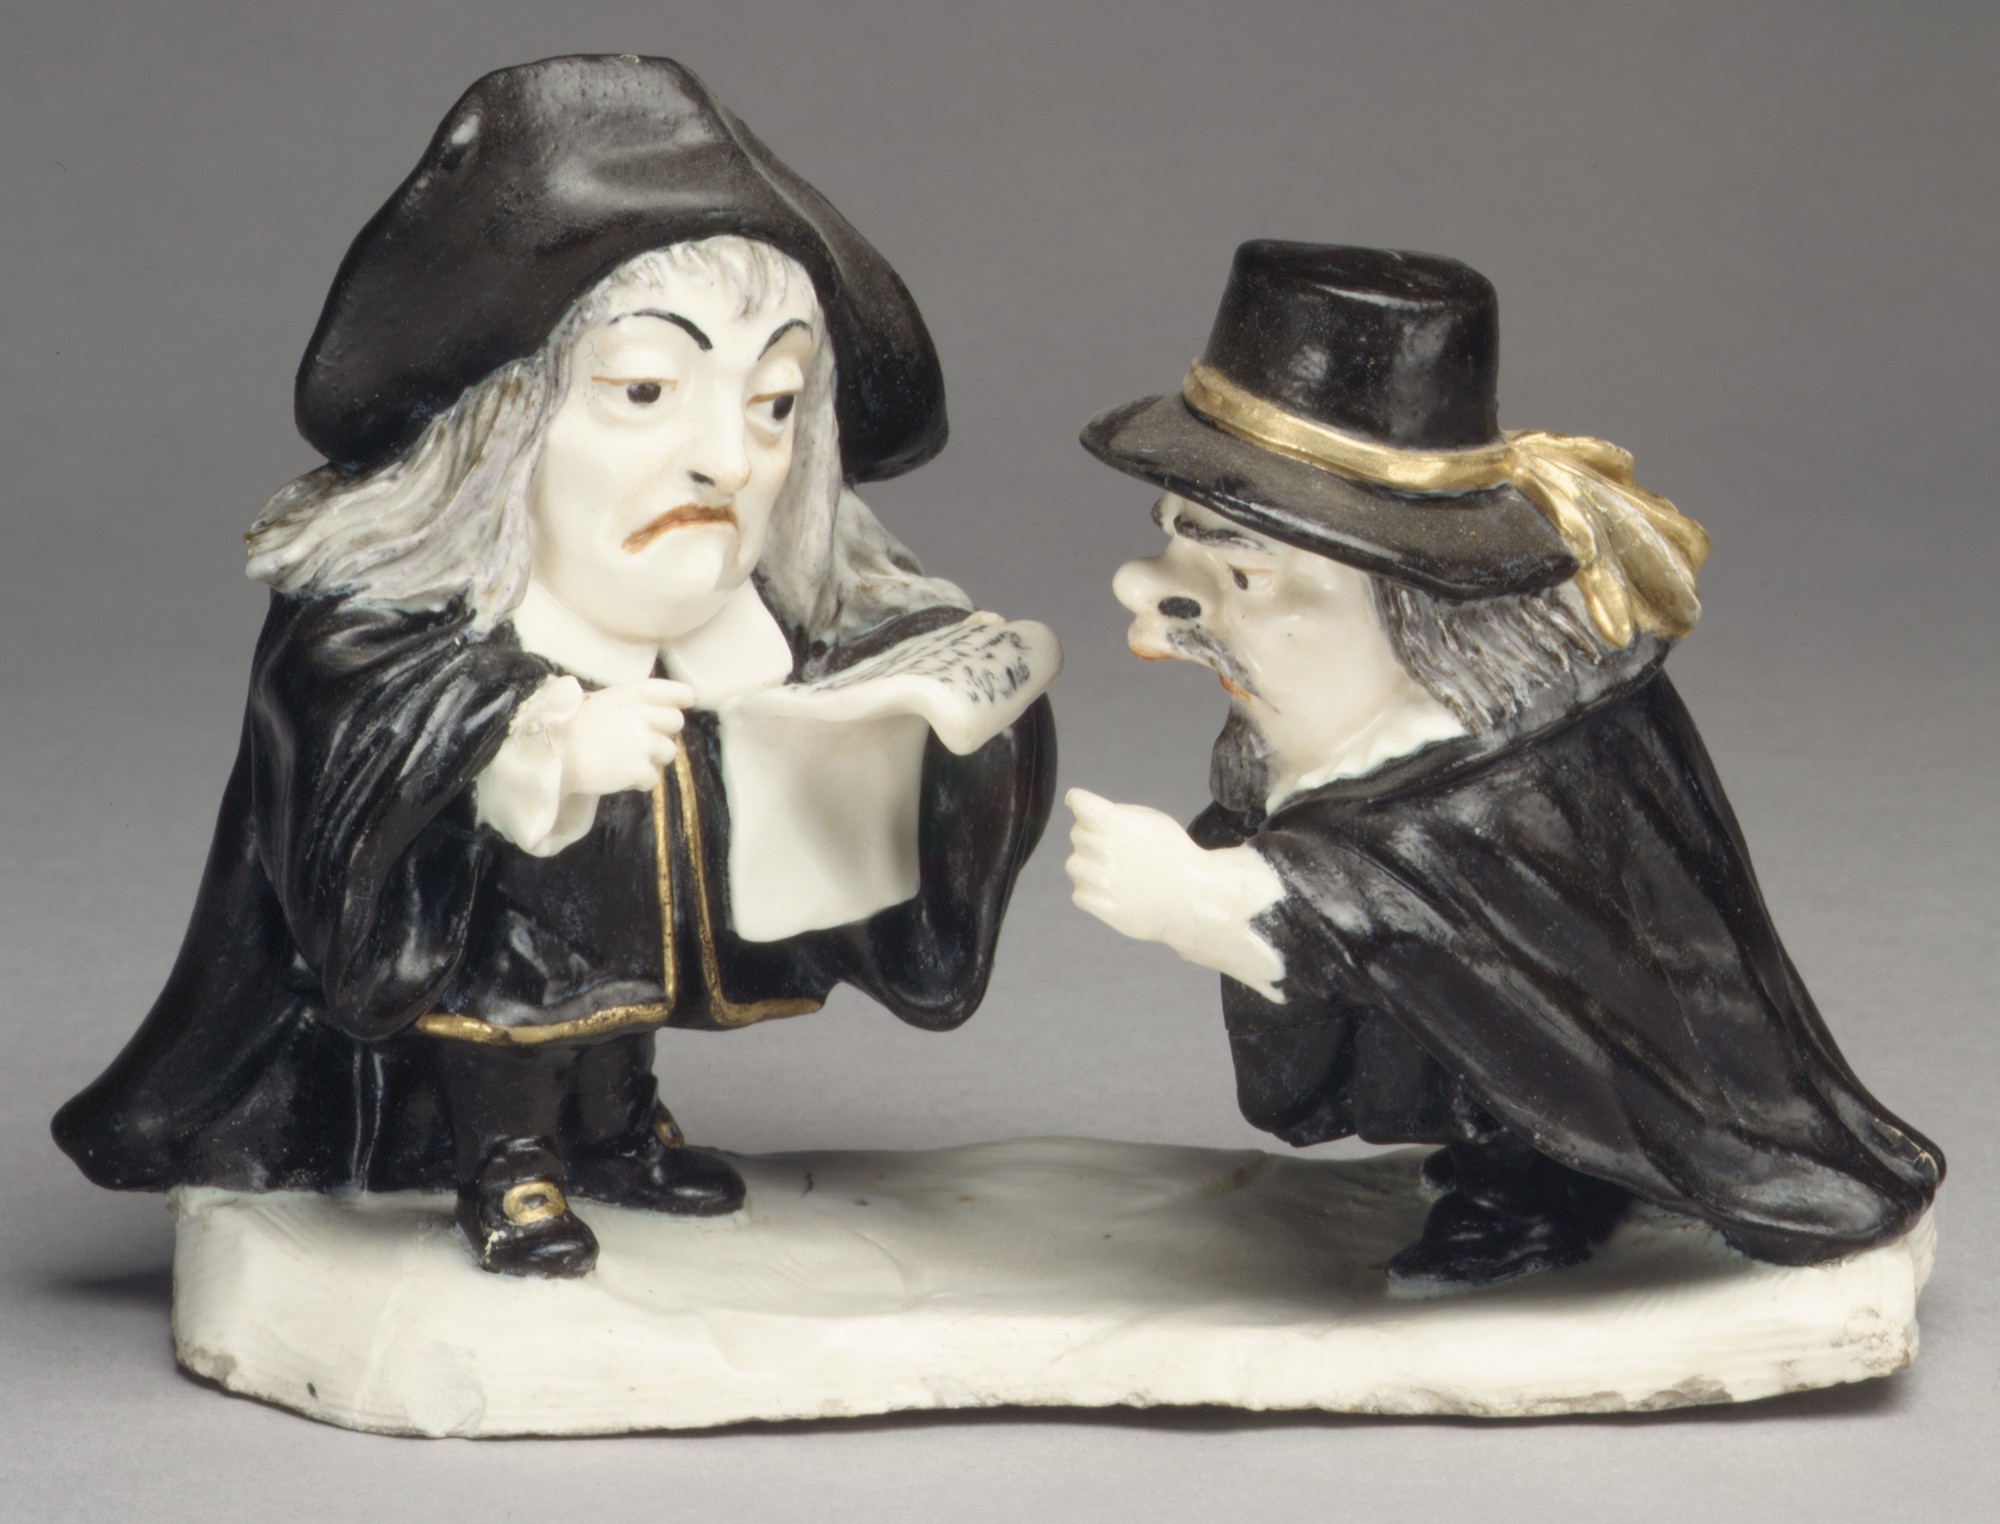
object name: group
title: Lawyers in dispute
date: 1770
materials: hard paste porcelain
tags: men